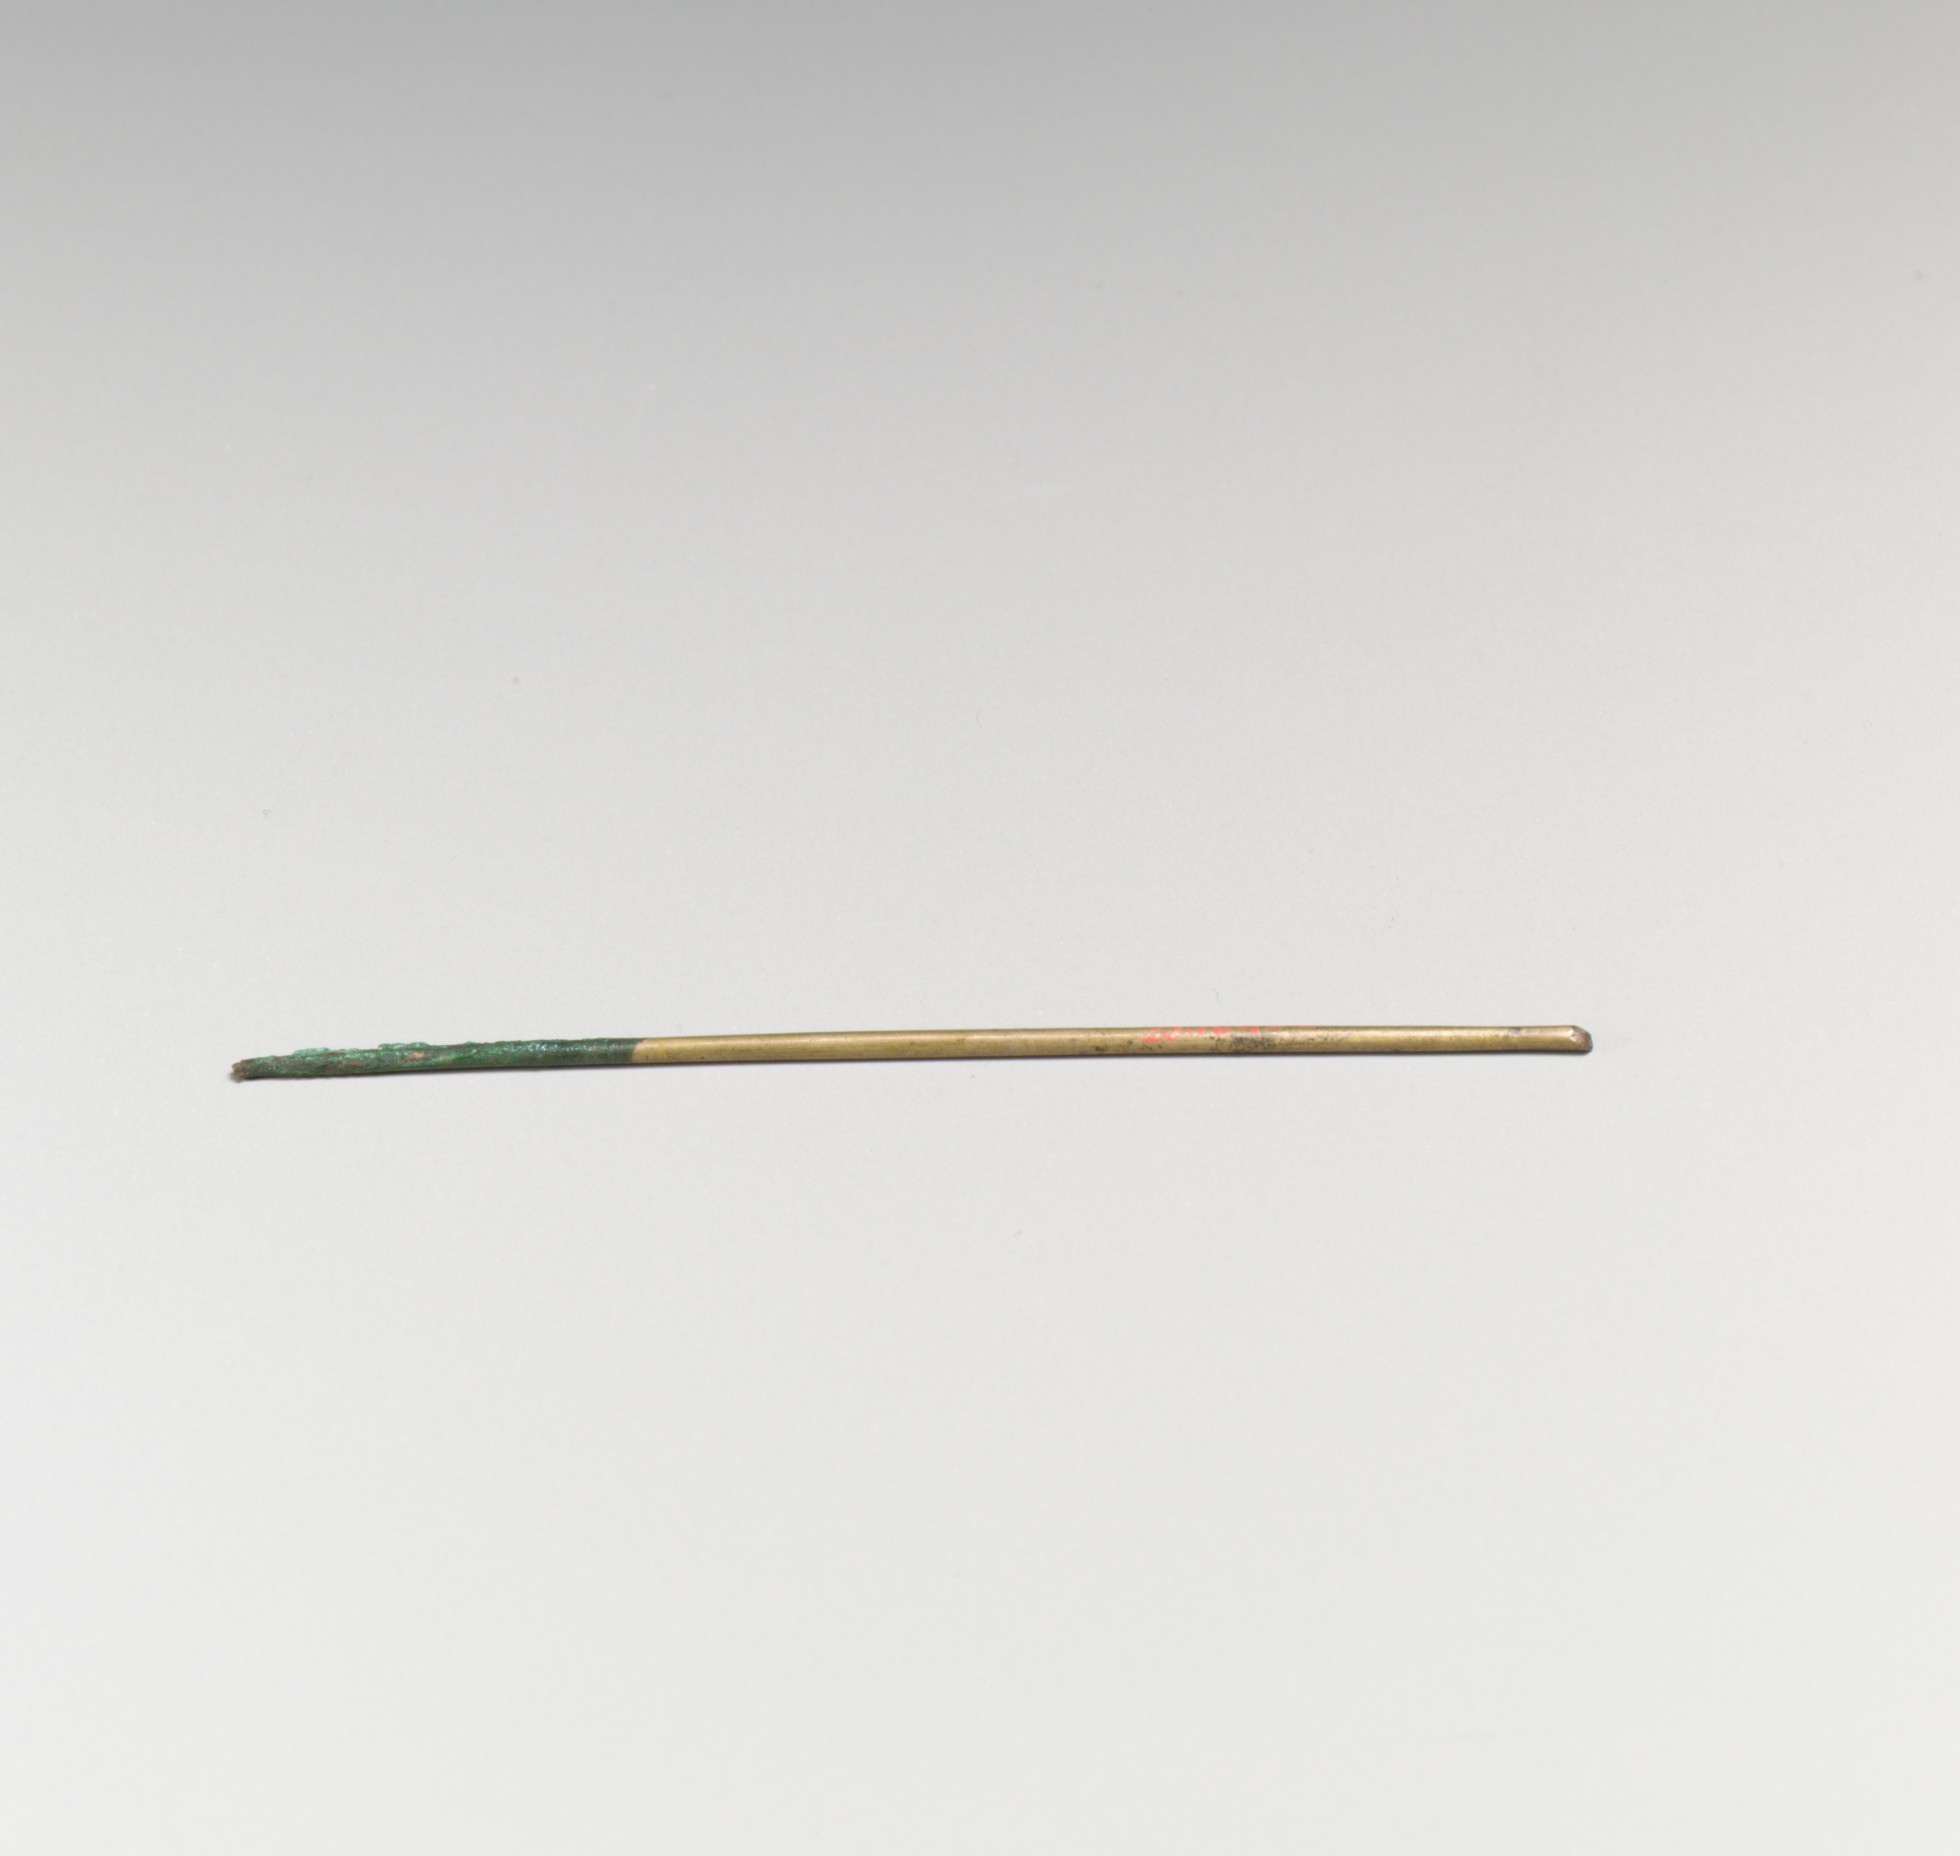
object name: object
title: Object ?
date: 7000 BCE-330 CE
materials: bronze